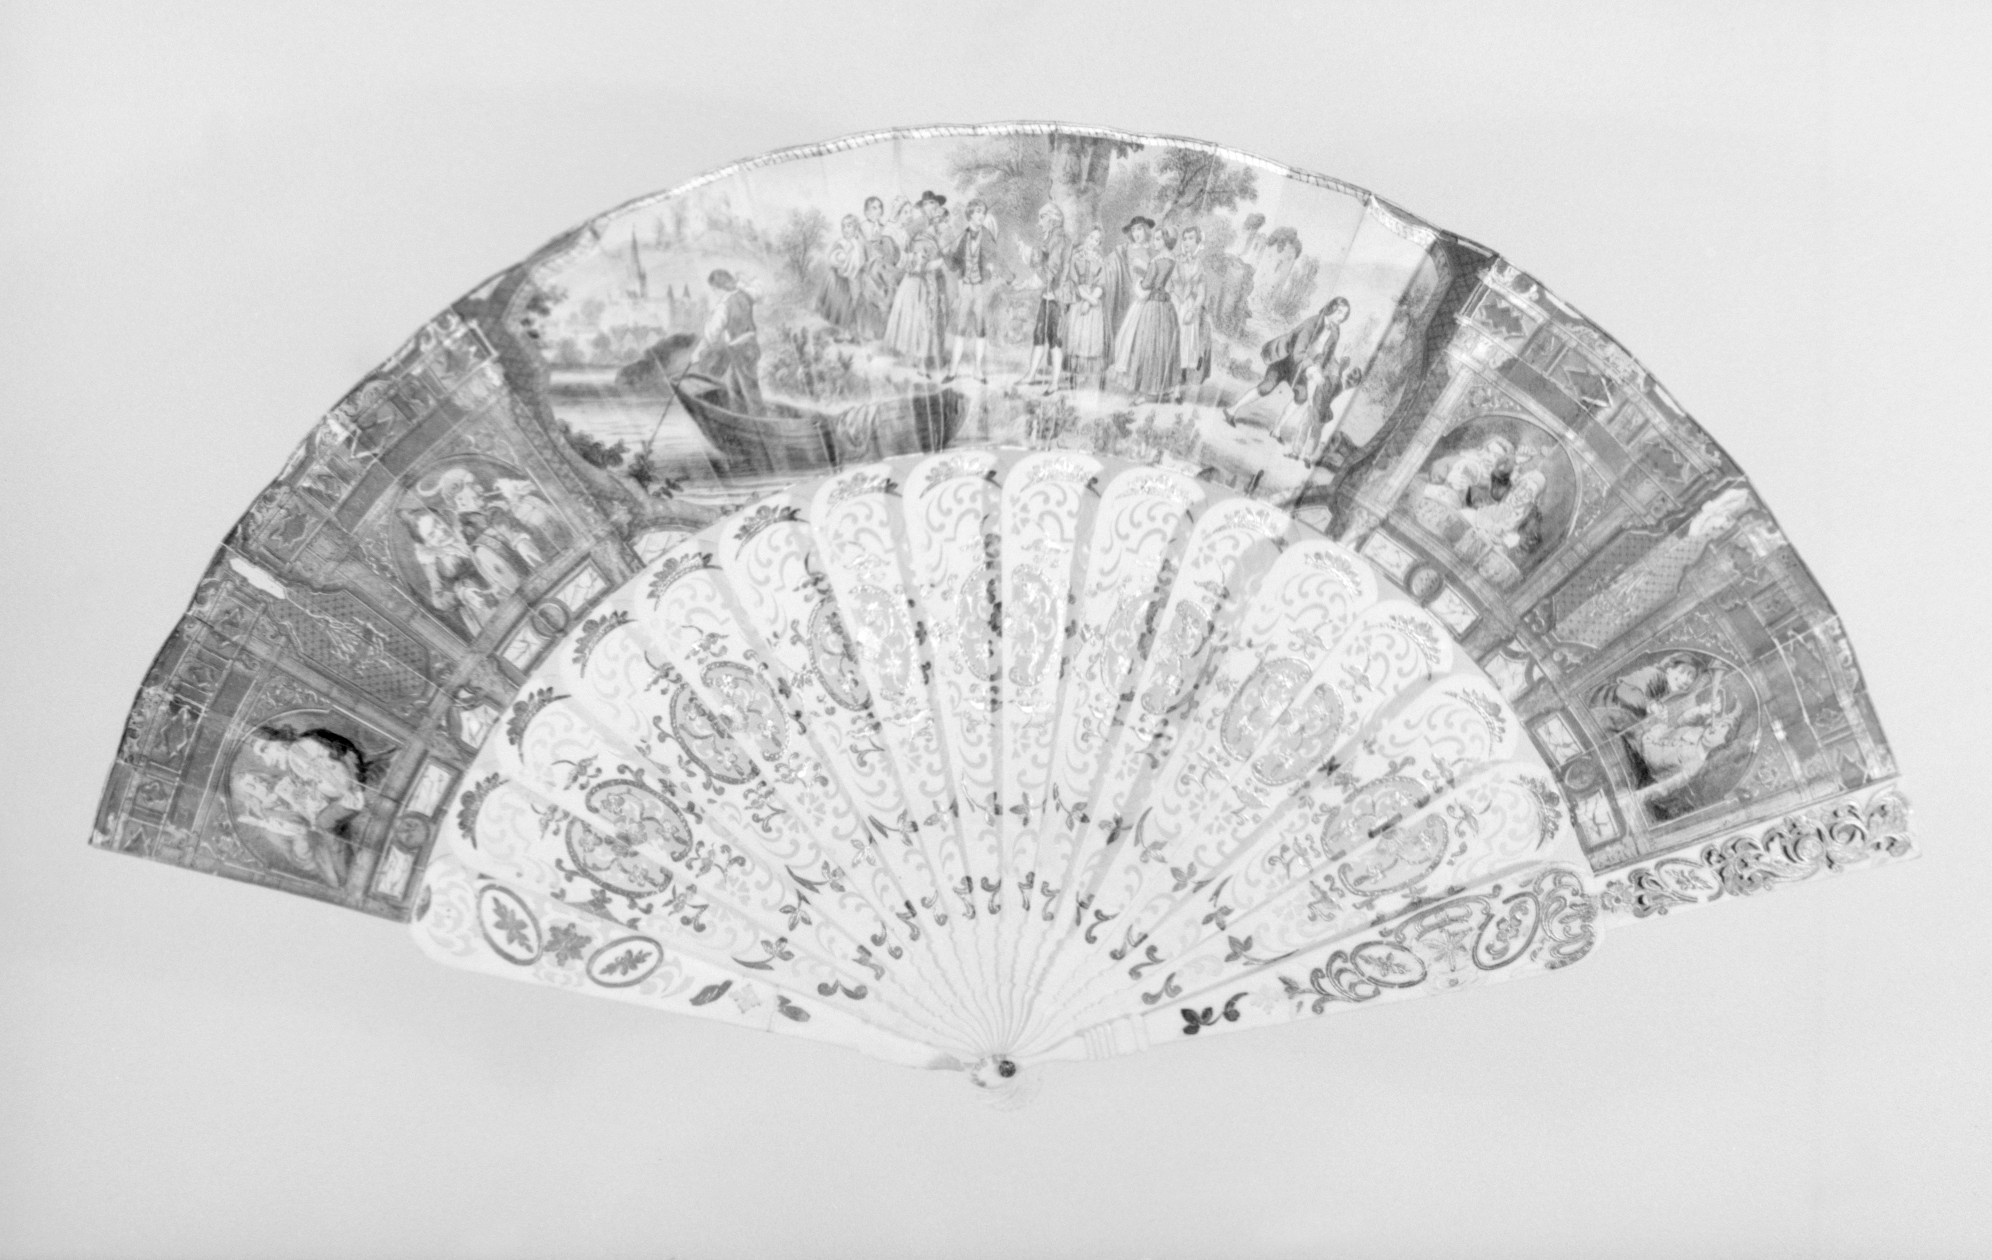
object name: fan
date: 1834-1866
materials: glass, gold, ivory, paint, paper, silver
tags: men,women,boats